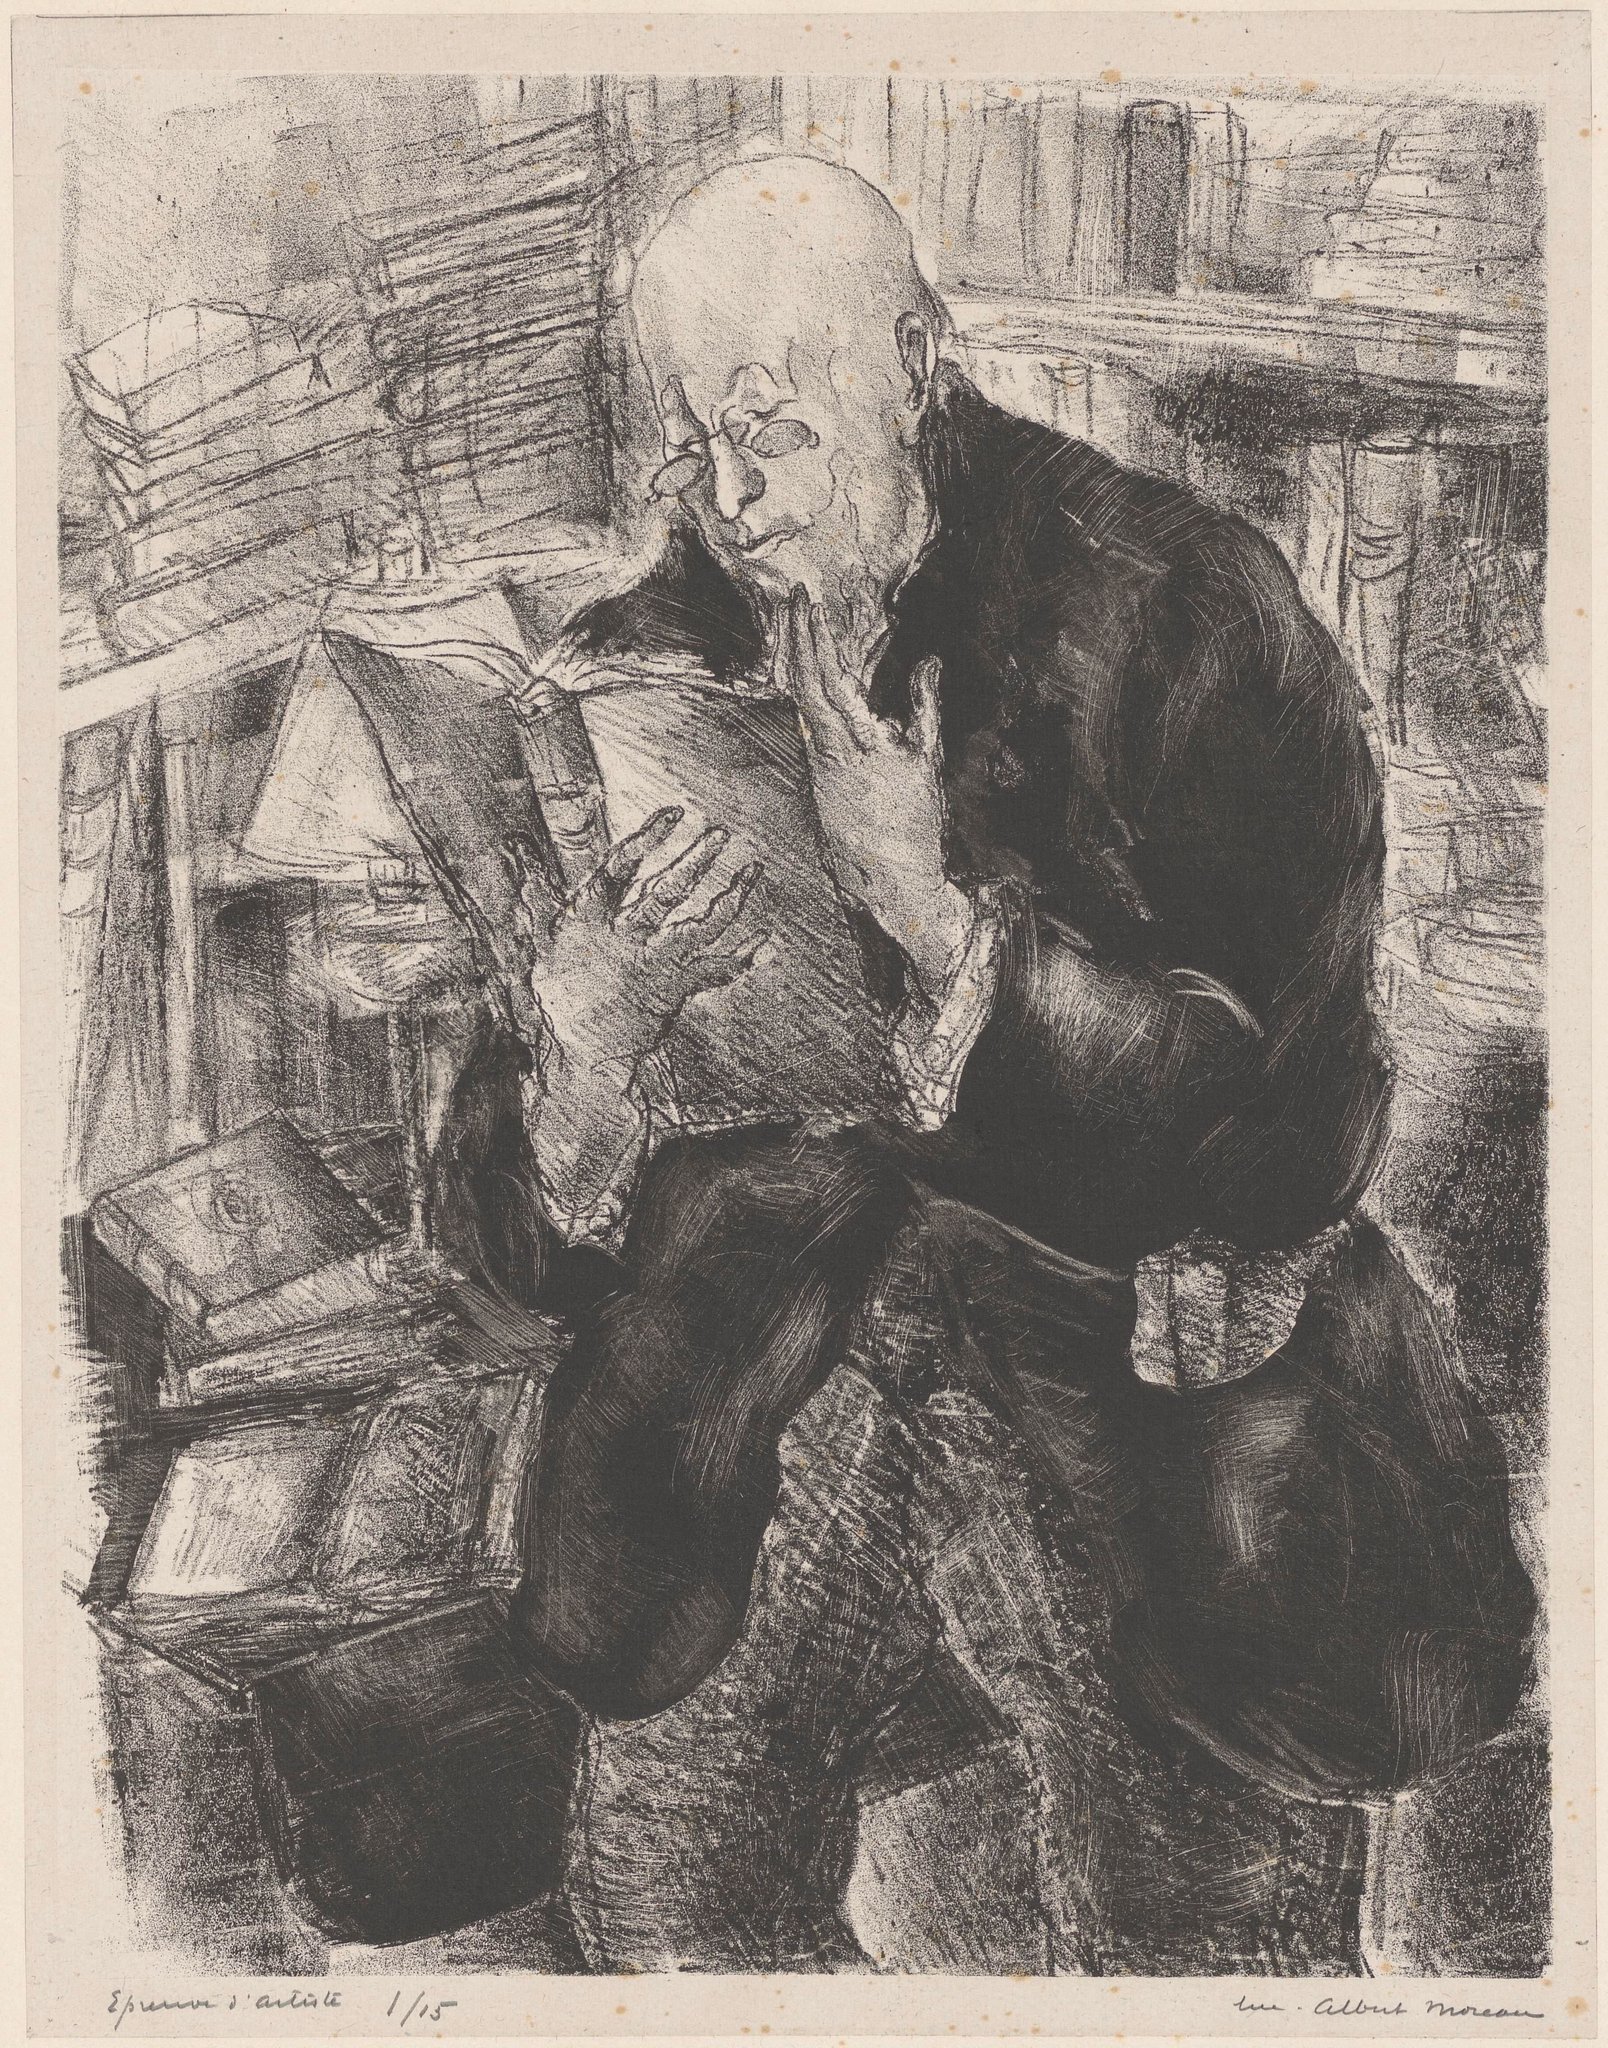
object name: print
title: Lezende man in een bibliotheek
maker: luc-albert moreau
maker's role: print maker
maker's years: 1882-1948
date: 1892-1948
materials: paper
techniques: lithograph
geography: paris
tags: eyeglasses, spectacles, reading, study; 'studiolo'; library, book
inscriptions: annotation: ‘eprueve d'artiste 1/15’, collector's mark: Lugt 4779, collector's mark: Lugt 2228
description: In een vertrek vol boeken staat een kale man met een boek in zijn handen. Op zijn neus draagt hij een pince-nez.